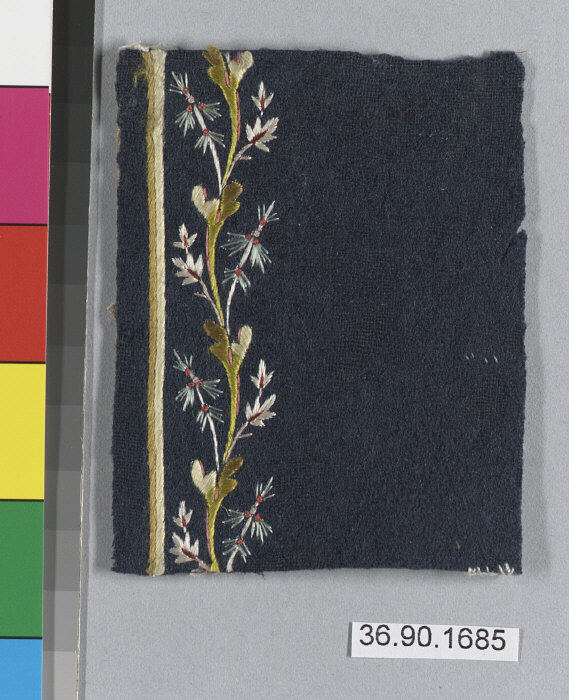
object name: sample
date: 1801-1833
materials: felt, silk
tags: flowers